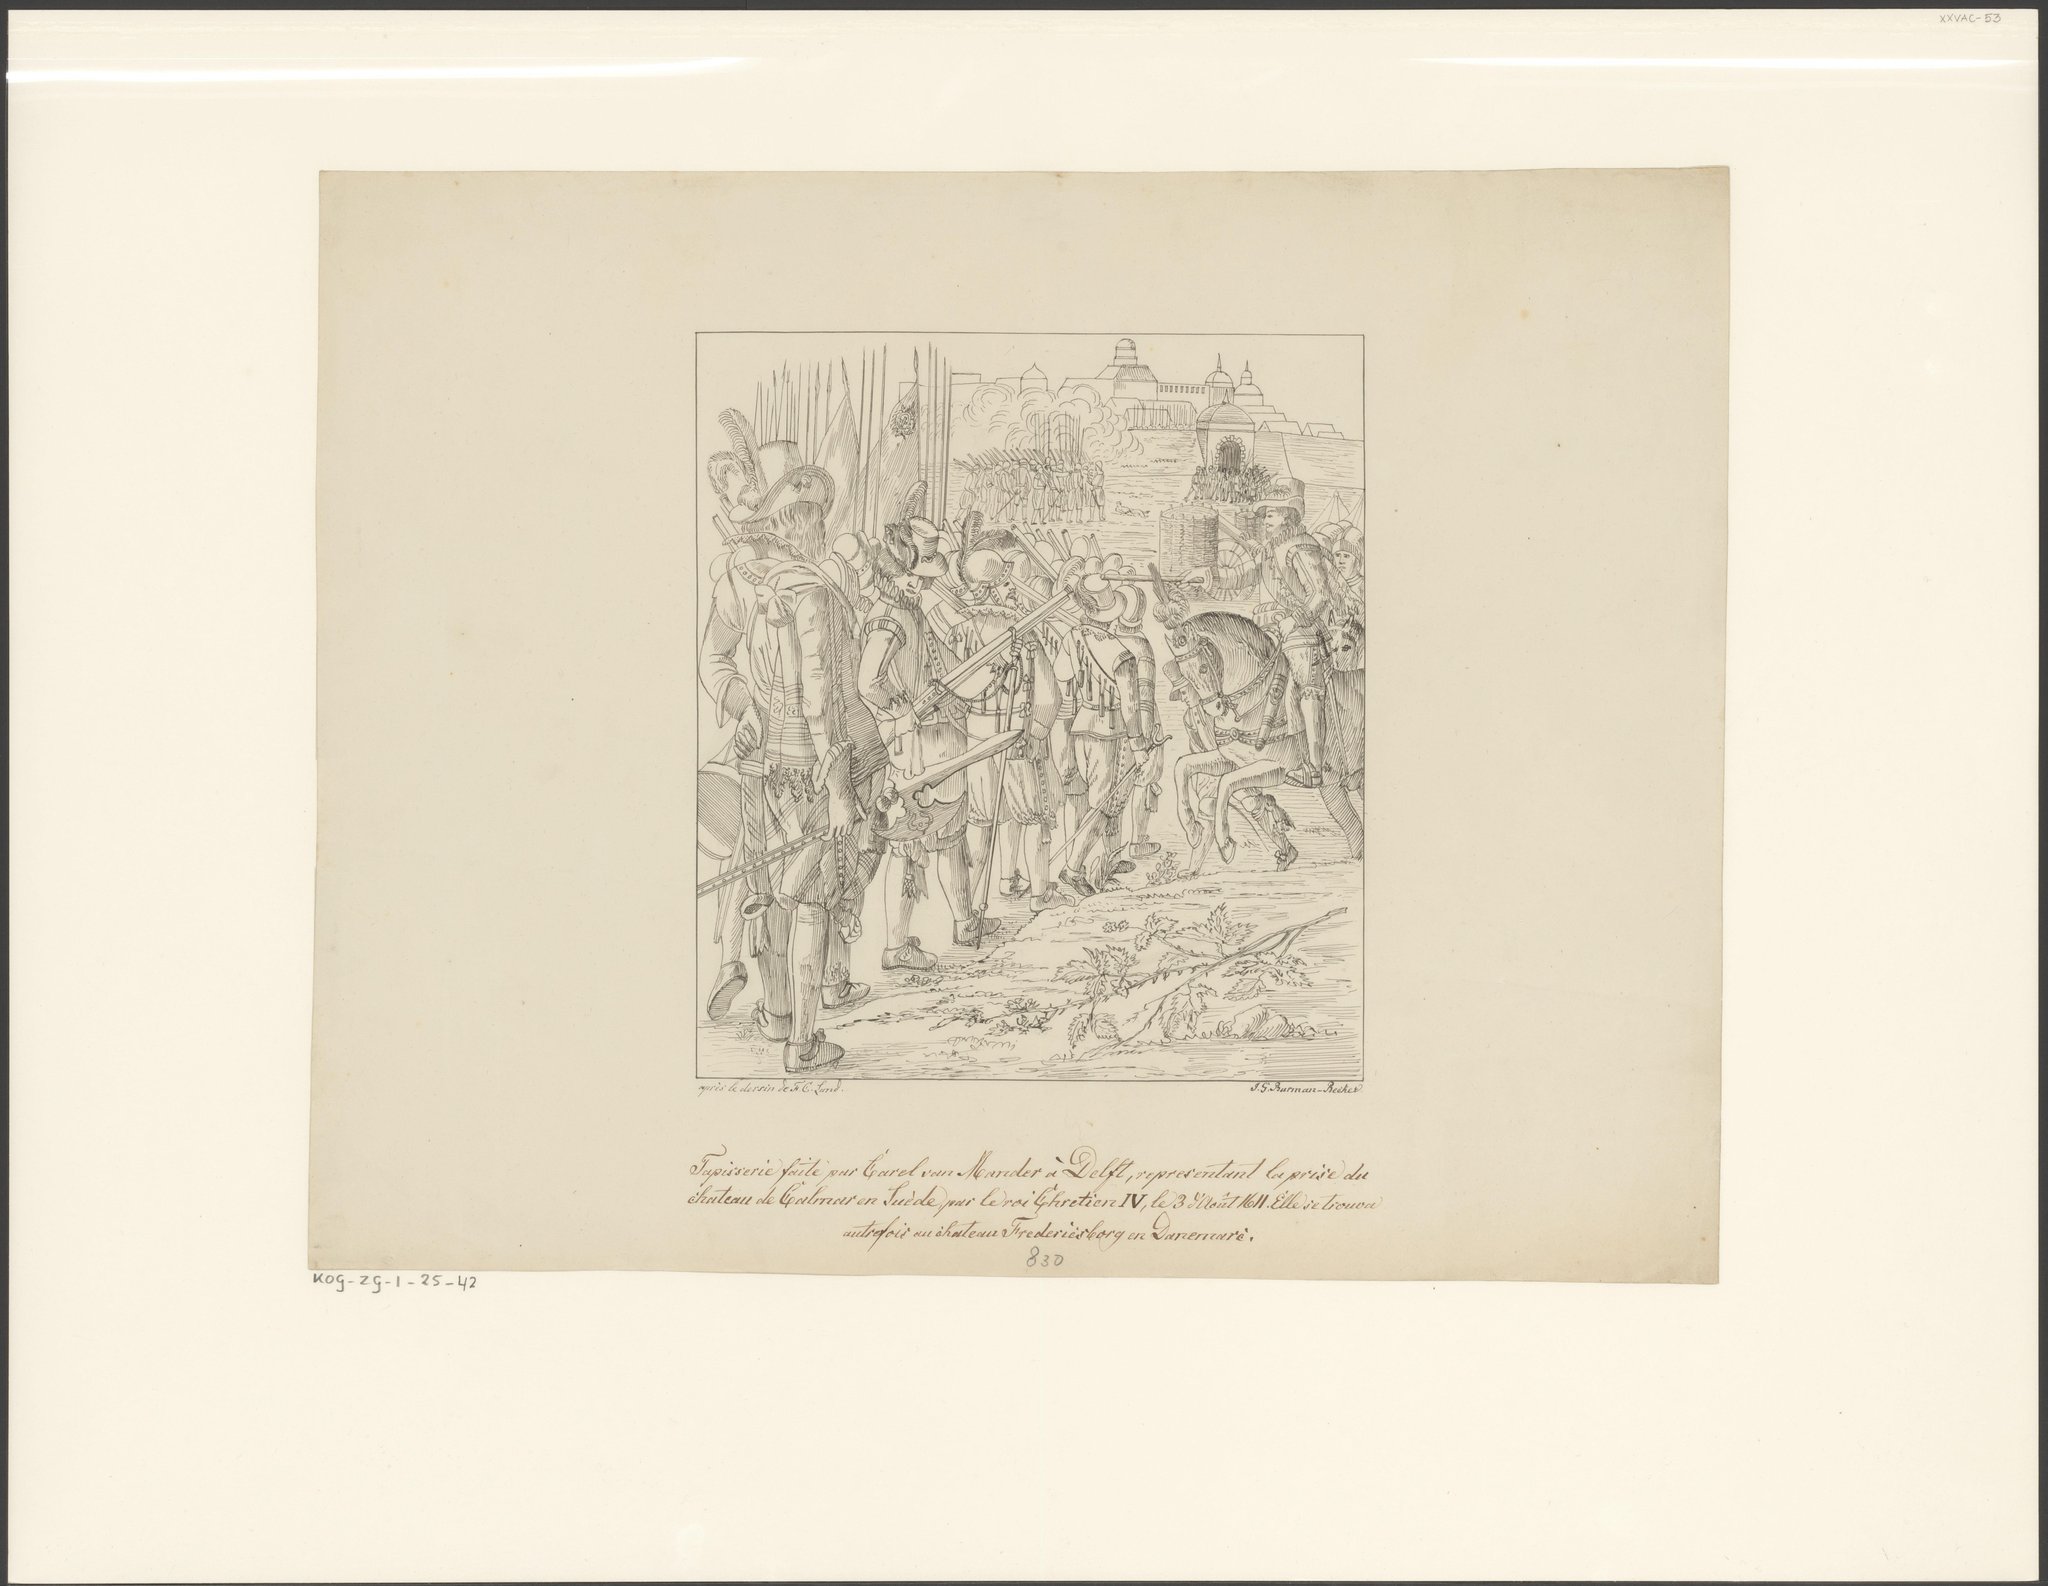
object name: print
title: Aanval op het Kalmar slott door Christiaan IV, koning van Denemarken en Noorwegen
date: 1870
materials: paper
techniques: lithograph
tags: christiaan iv (koning van denemarken en noorwegen), castle, siege, delft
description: Onderwerpsrubrieken binnen de Atlas Zeden en Gewoonten: Zeden en Gewoonten in Engeren Zin, De Woning, Binnenhuizen, Wandversiering.